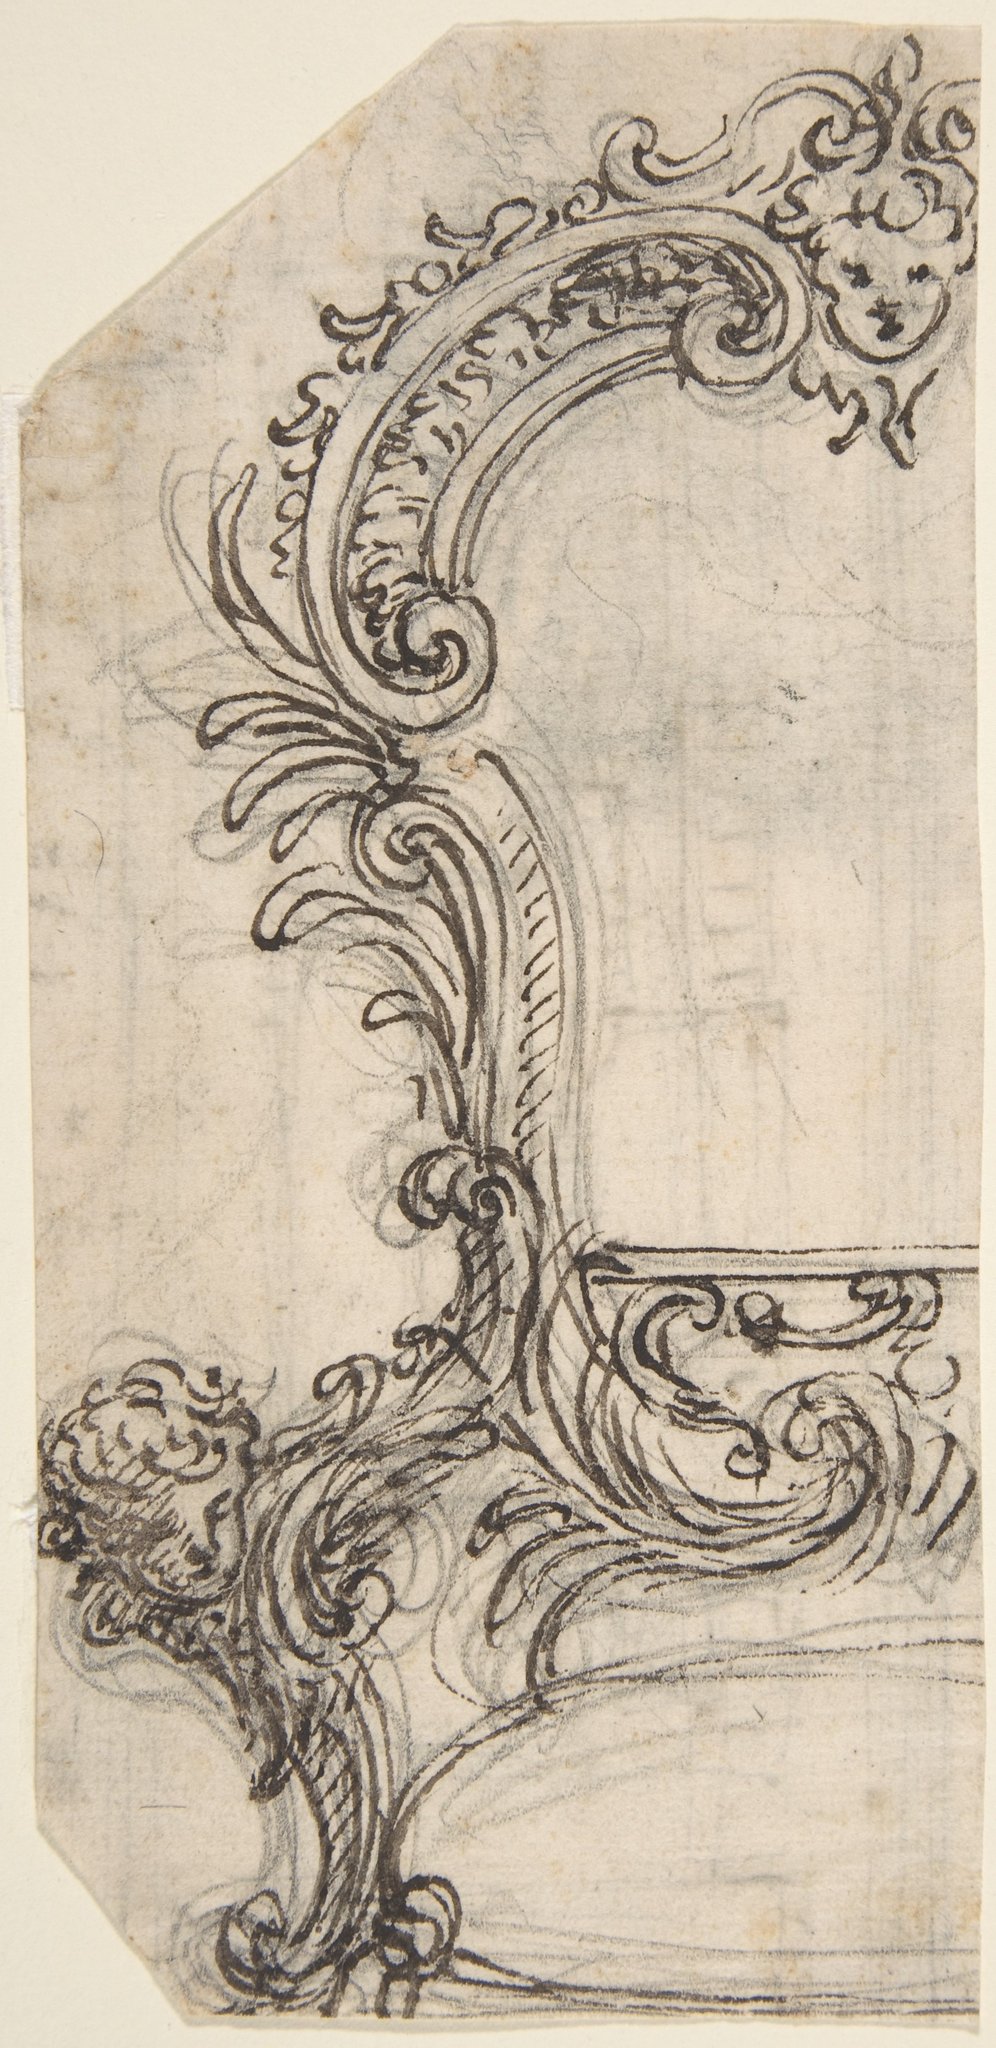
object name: drawing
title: Design for the Frame of a Mirror or Fire Screen (recto); Various Sketches (verso)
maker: giovanni battista foggini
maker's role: artist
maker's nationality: italian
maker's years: 1652-1725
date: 1672-1725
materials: chalk, ink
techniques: pen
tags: cartouches,mirrors